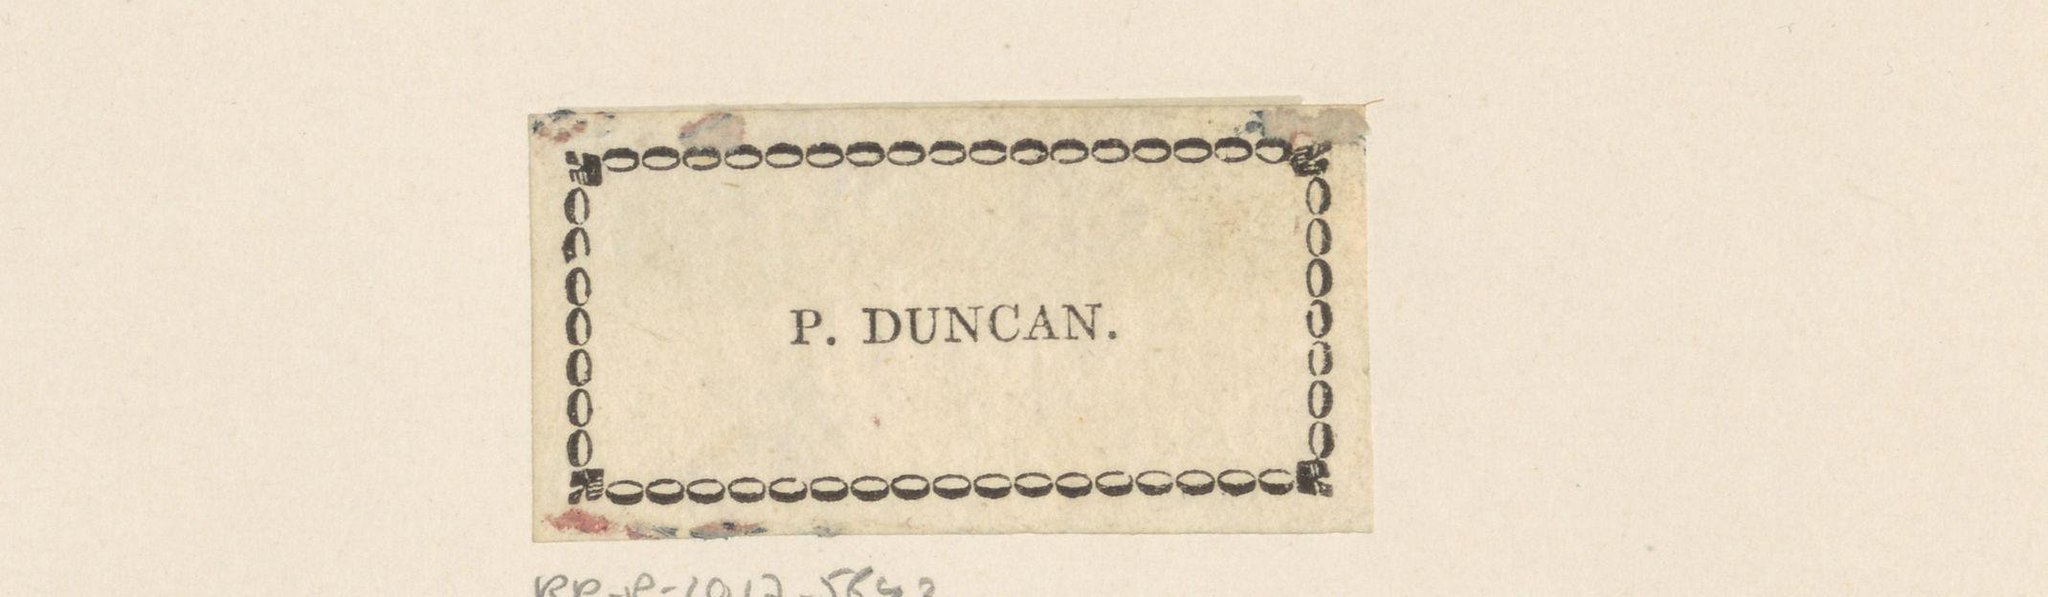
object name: bookplate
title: Ex libris van P. Duncan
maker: Anonymous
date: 1800-1899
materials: paper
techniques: letterpress printing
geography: england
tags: p. duncan